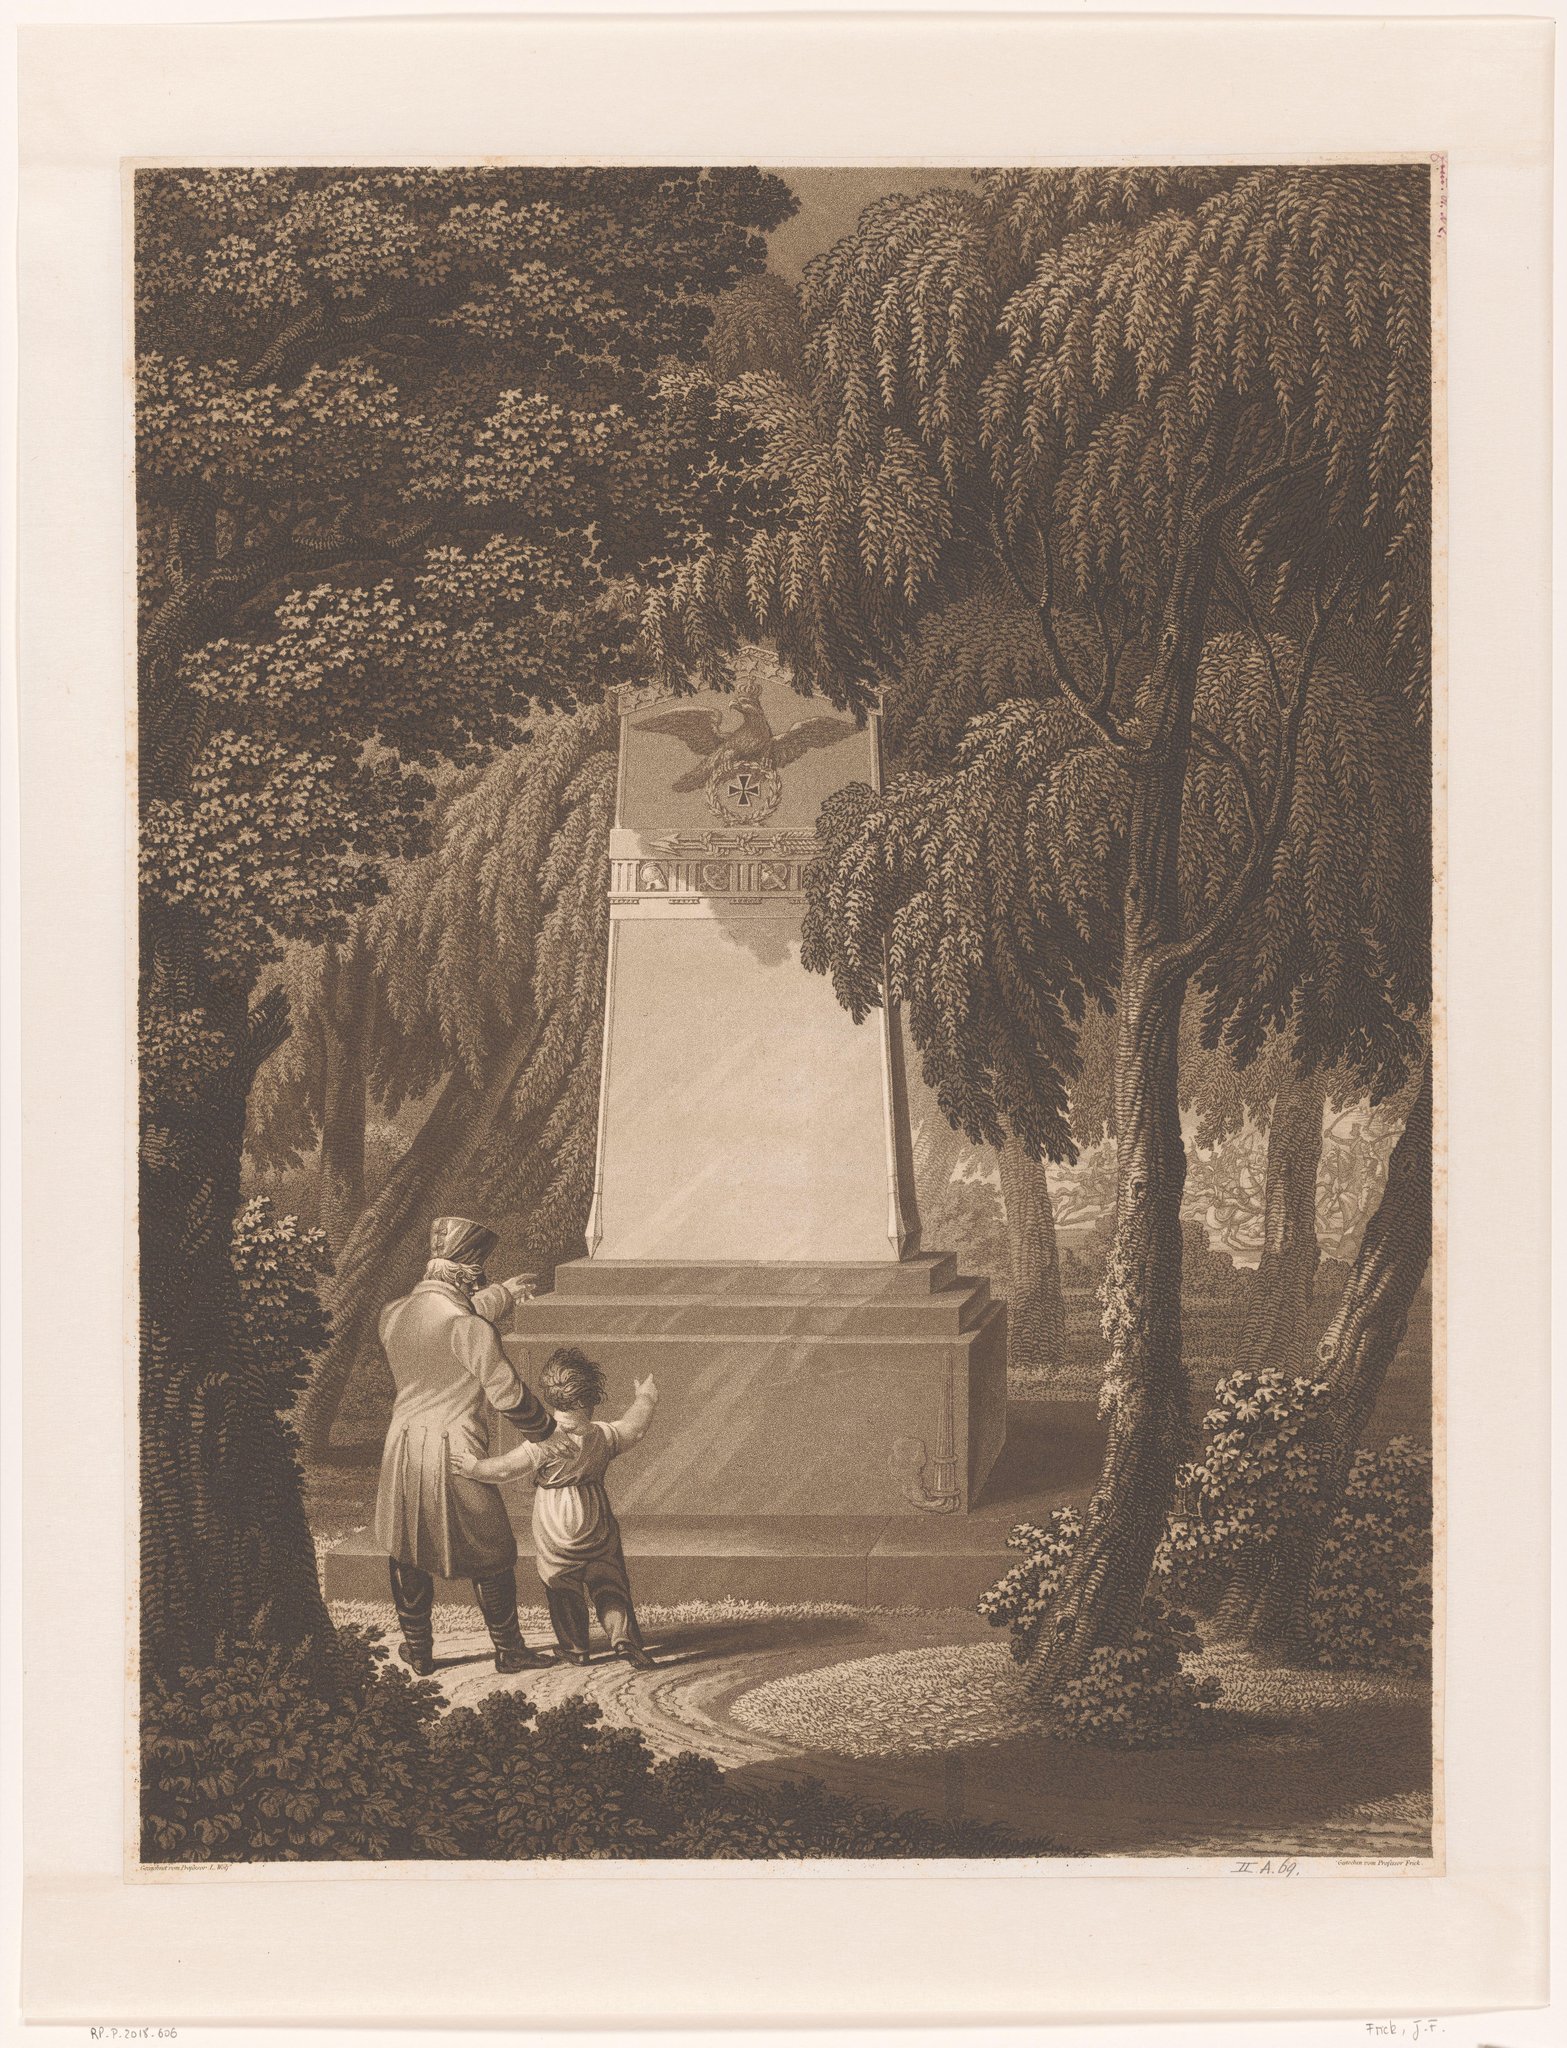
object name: print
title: Man met een kind voor een monument voor een omgekomen legerofficier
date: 1815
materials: paper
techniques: aquatint, etching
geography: berlin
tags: forest, wood, soldiers and civilians, grave-building, monumental tomb, germany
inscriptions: collector's mark: Lugt 2760, collector's mark: Lugt 2228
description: Man staande met een kind voor een monument voor een omgekomen legerofficier. Het monument zonder tekst. Bovenaan de Duitse keizerlijke adelaar met een ijzeren kruis binnen een laurierkrans, daaronder enkele bijeen gebonden pijlen. Op de voet van het monument een omgekeerde toorts.